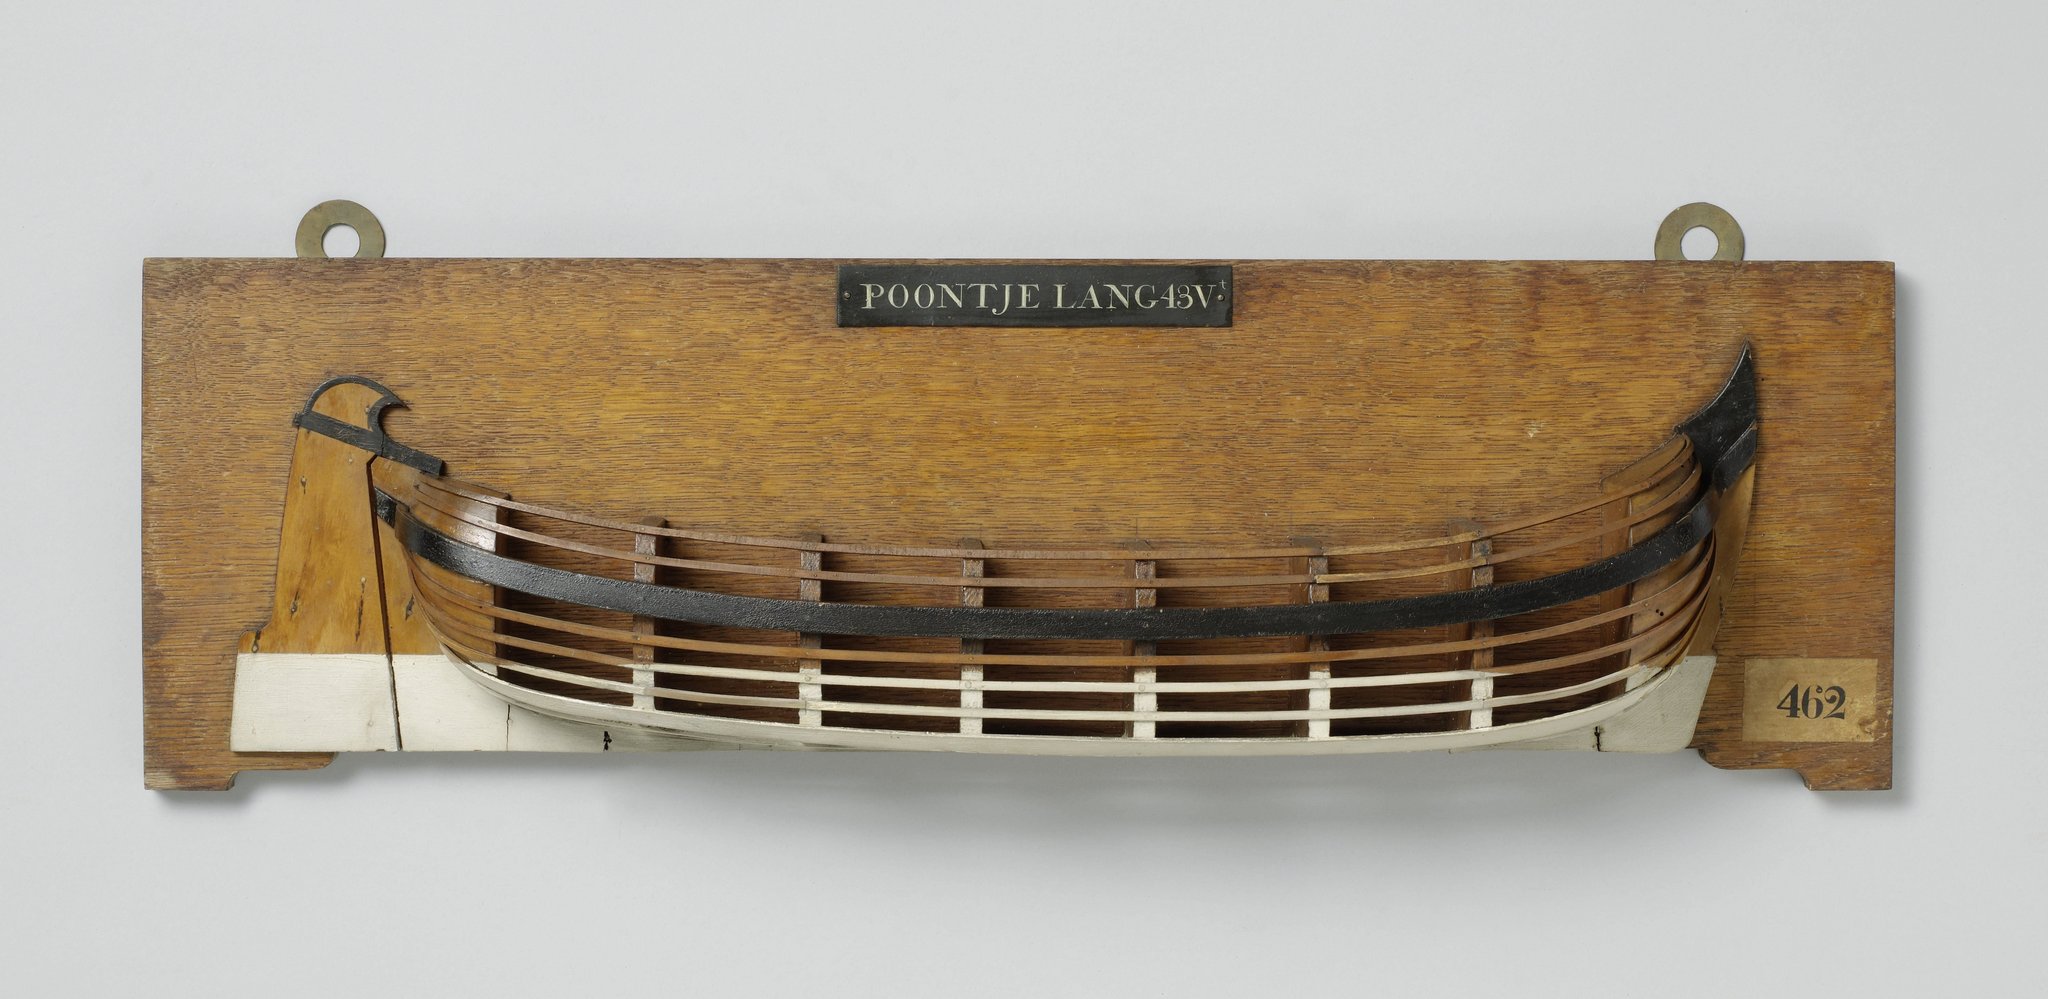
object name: builder's model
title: Half Model of a Poon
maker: Anonymous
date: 1780-1820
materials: wood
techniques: polychromy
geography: netherlands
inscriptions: inscription, top centre, on a rectangular black label: ‘POONTJE LANG 43 Vt’, label, bottom right: ‘462’ former inventory label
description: Gepolychromeerd mallenmodel (stuurboord) van een platbodem. Rond achterschip, breed roer. De zeeg loopt naar beide uiteinden op, één barkhout doorlopend op voor- en achtersteven. Schaal ca. 1:24 (afgeleid).